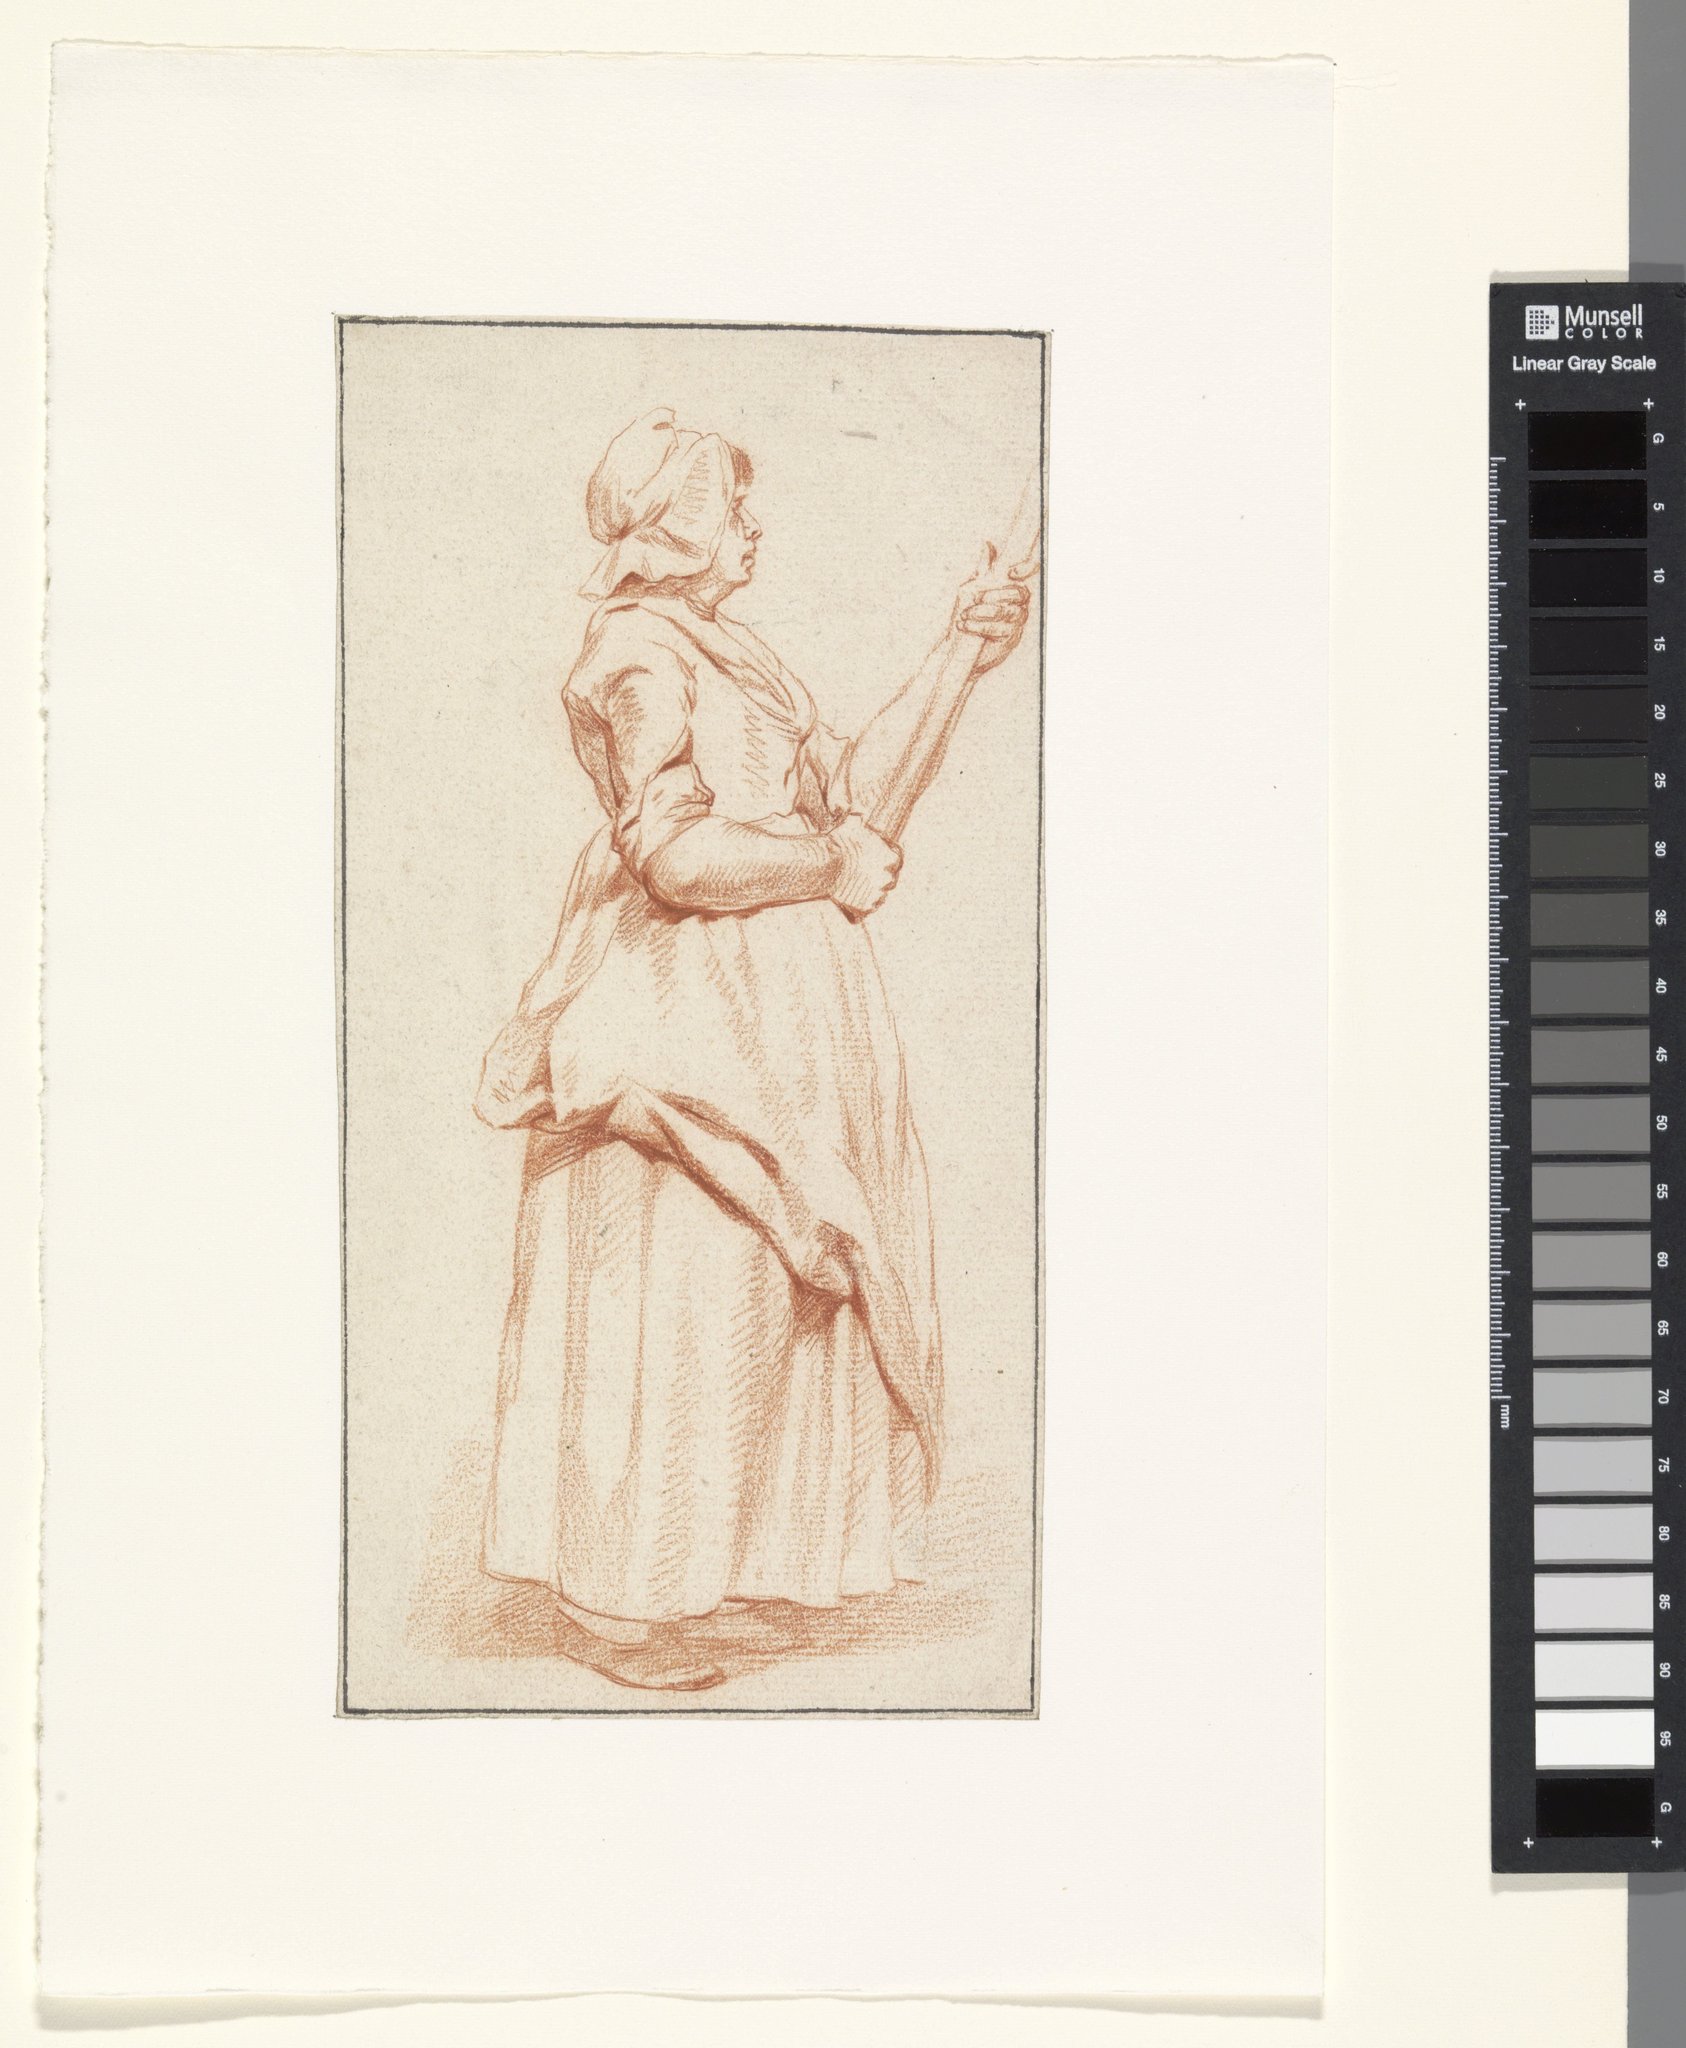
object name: drawing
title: Vrouw met stok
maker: jan anton garemyn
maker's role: draughtsman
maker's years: 1712-1799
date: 1722-1799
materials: chalk, paper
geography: netherlands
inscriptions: collector's mark: Lugt 2228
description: Staande vrouw met een stok in beide handen, en profil gezien.